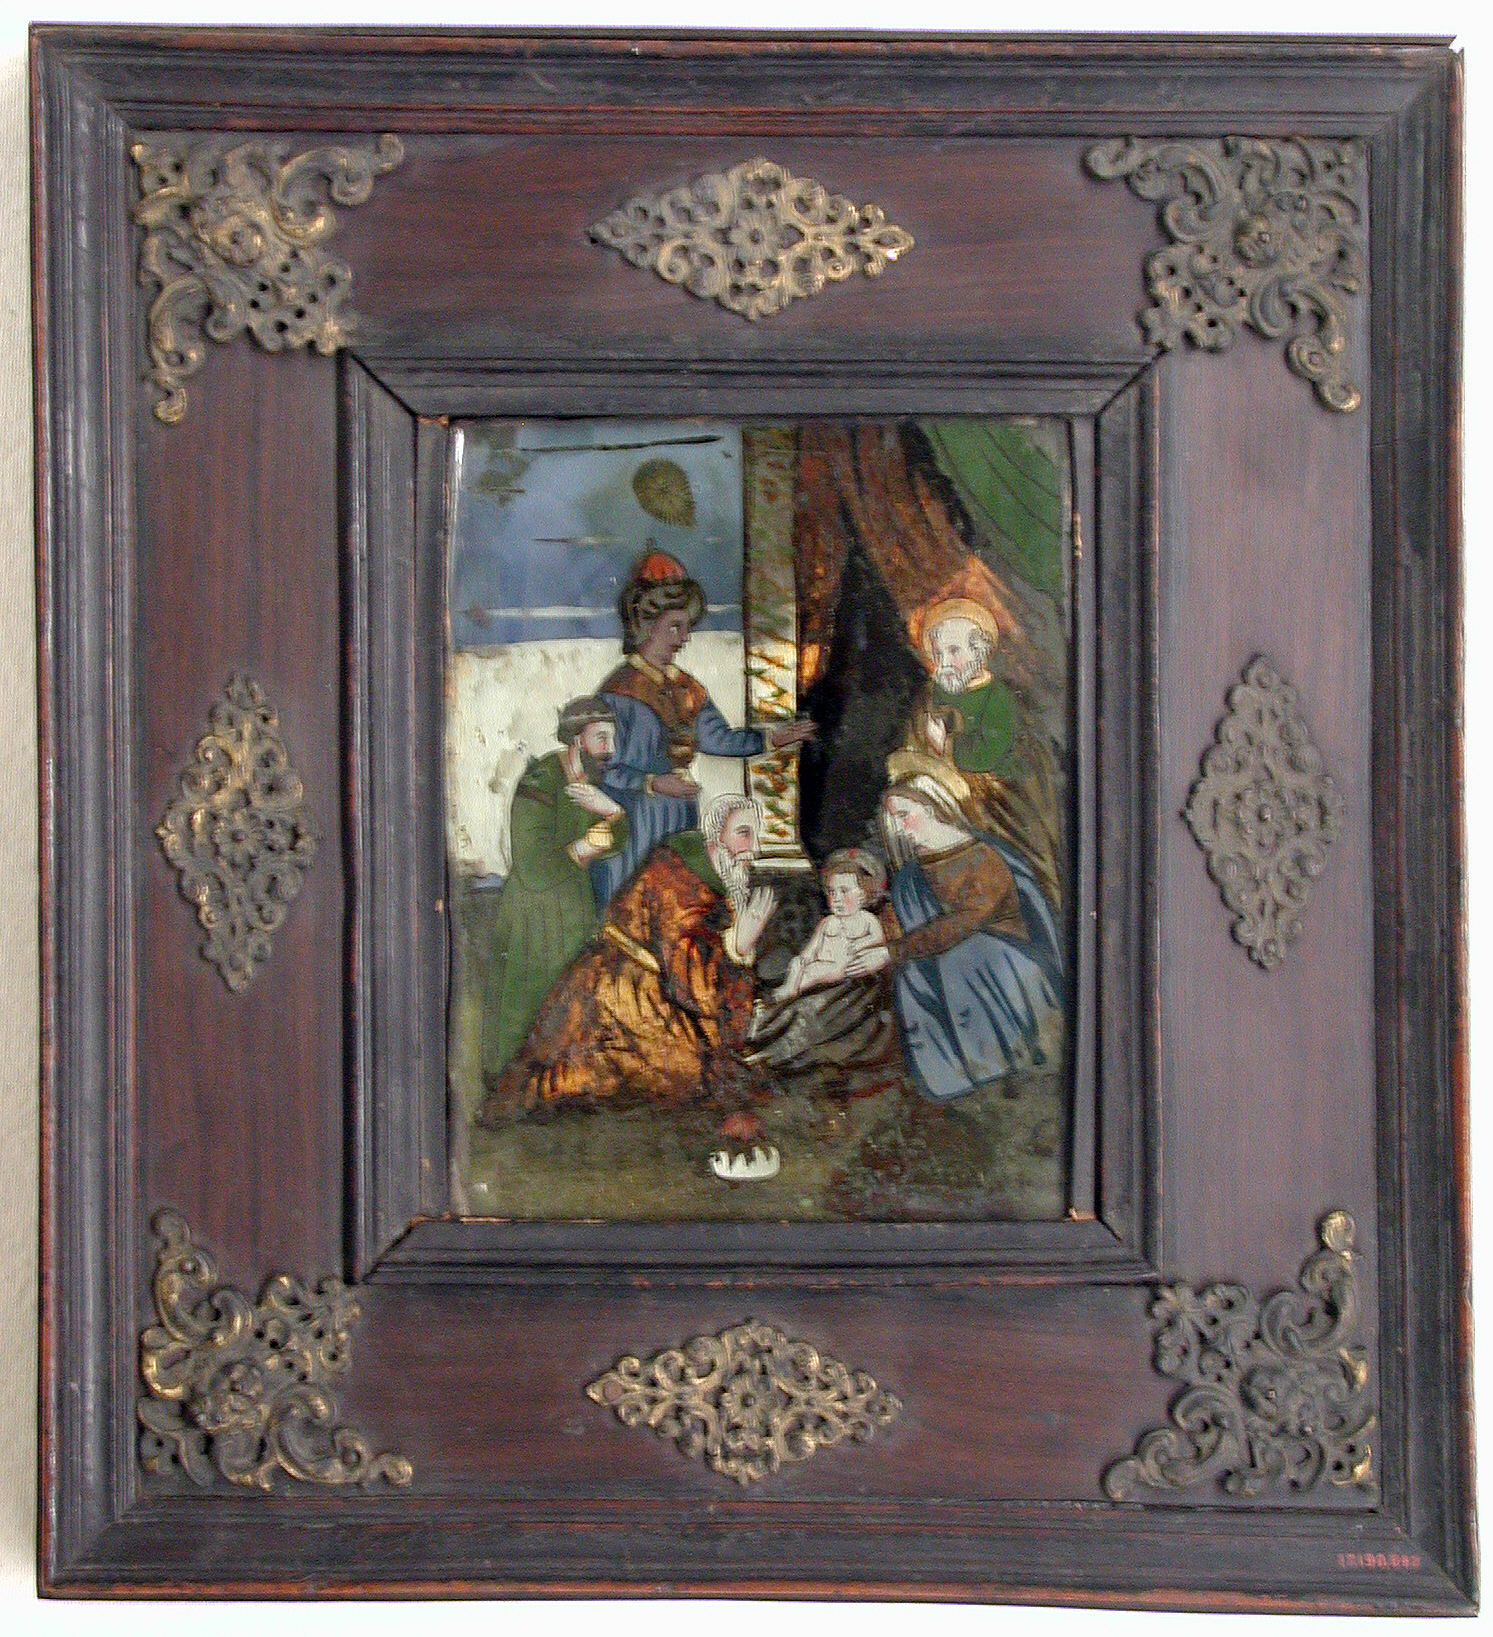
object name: panel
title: Adoration of the Magi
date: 1501-1600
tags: virgin mary,jesus,adoration of the magi